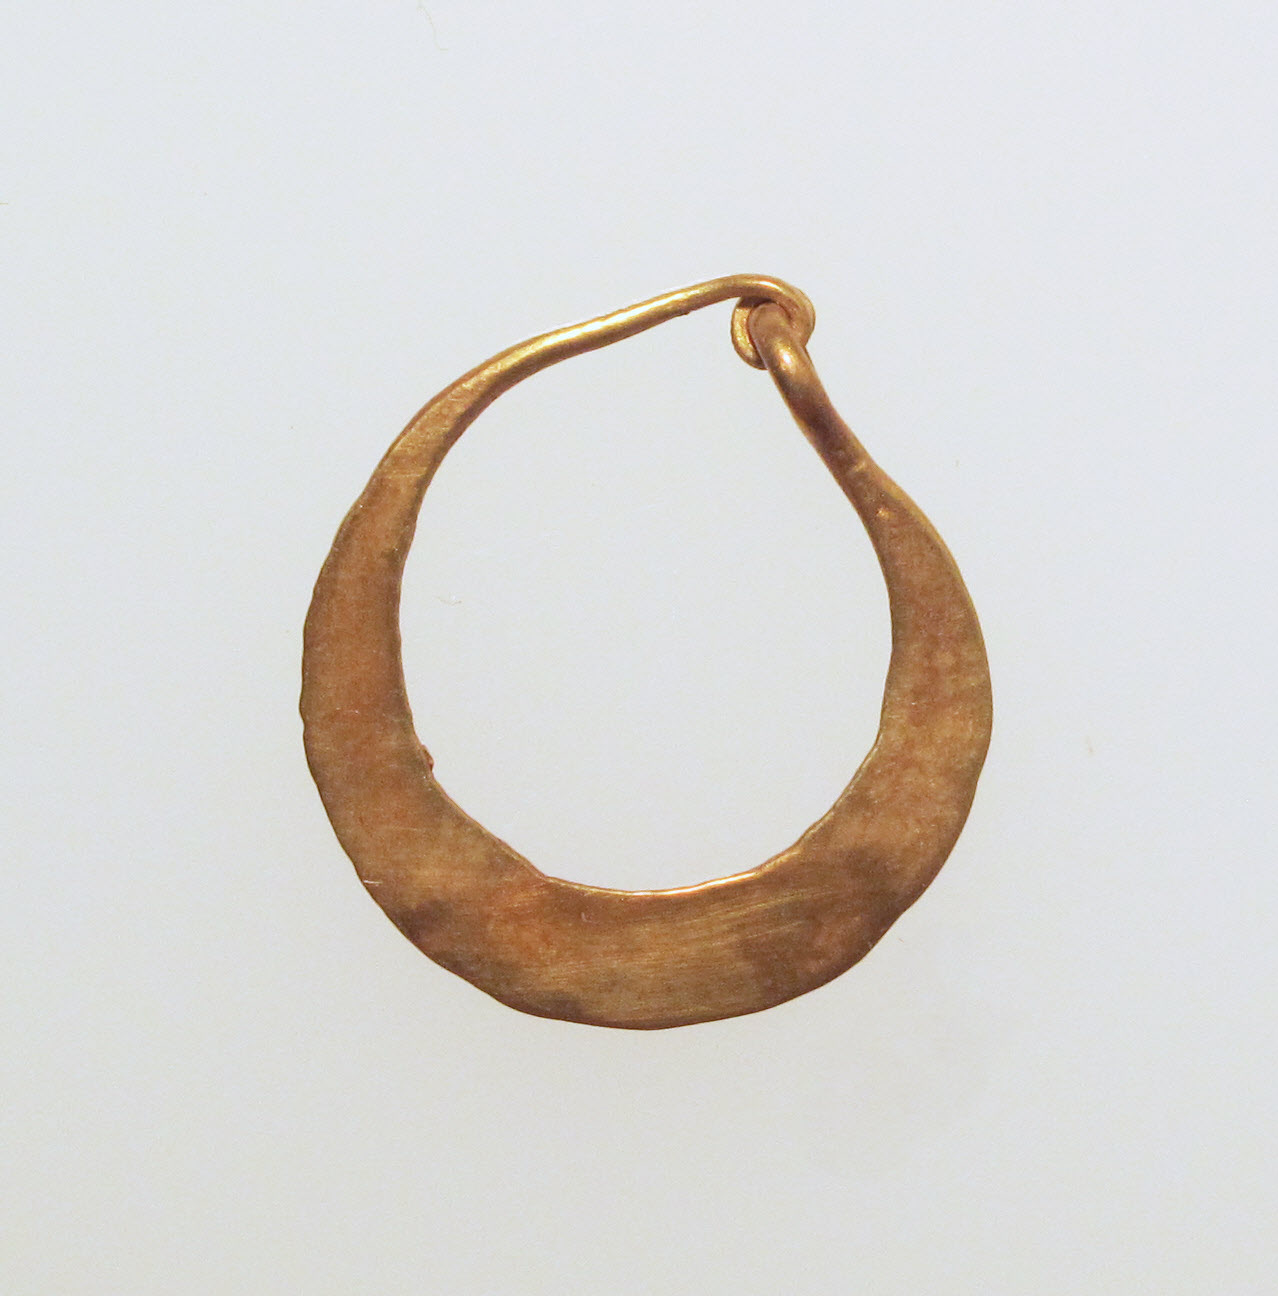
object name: earring, crescent shaped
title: Earring, crescent-shaped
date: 7000 BCE-330 CE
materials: gold